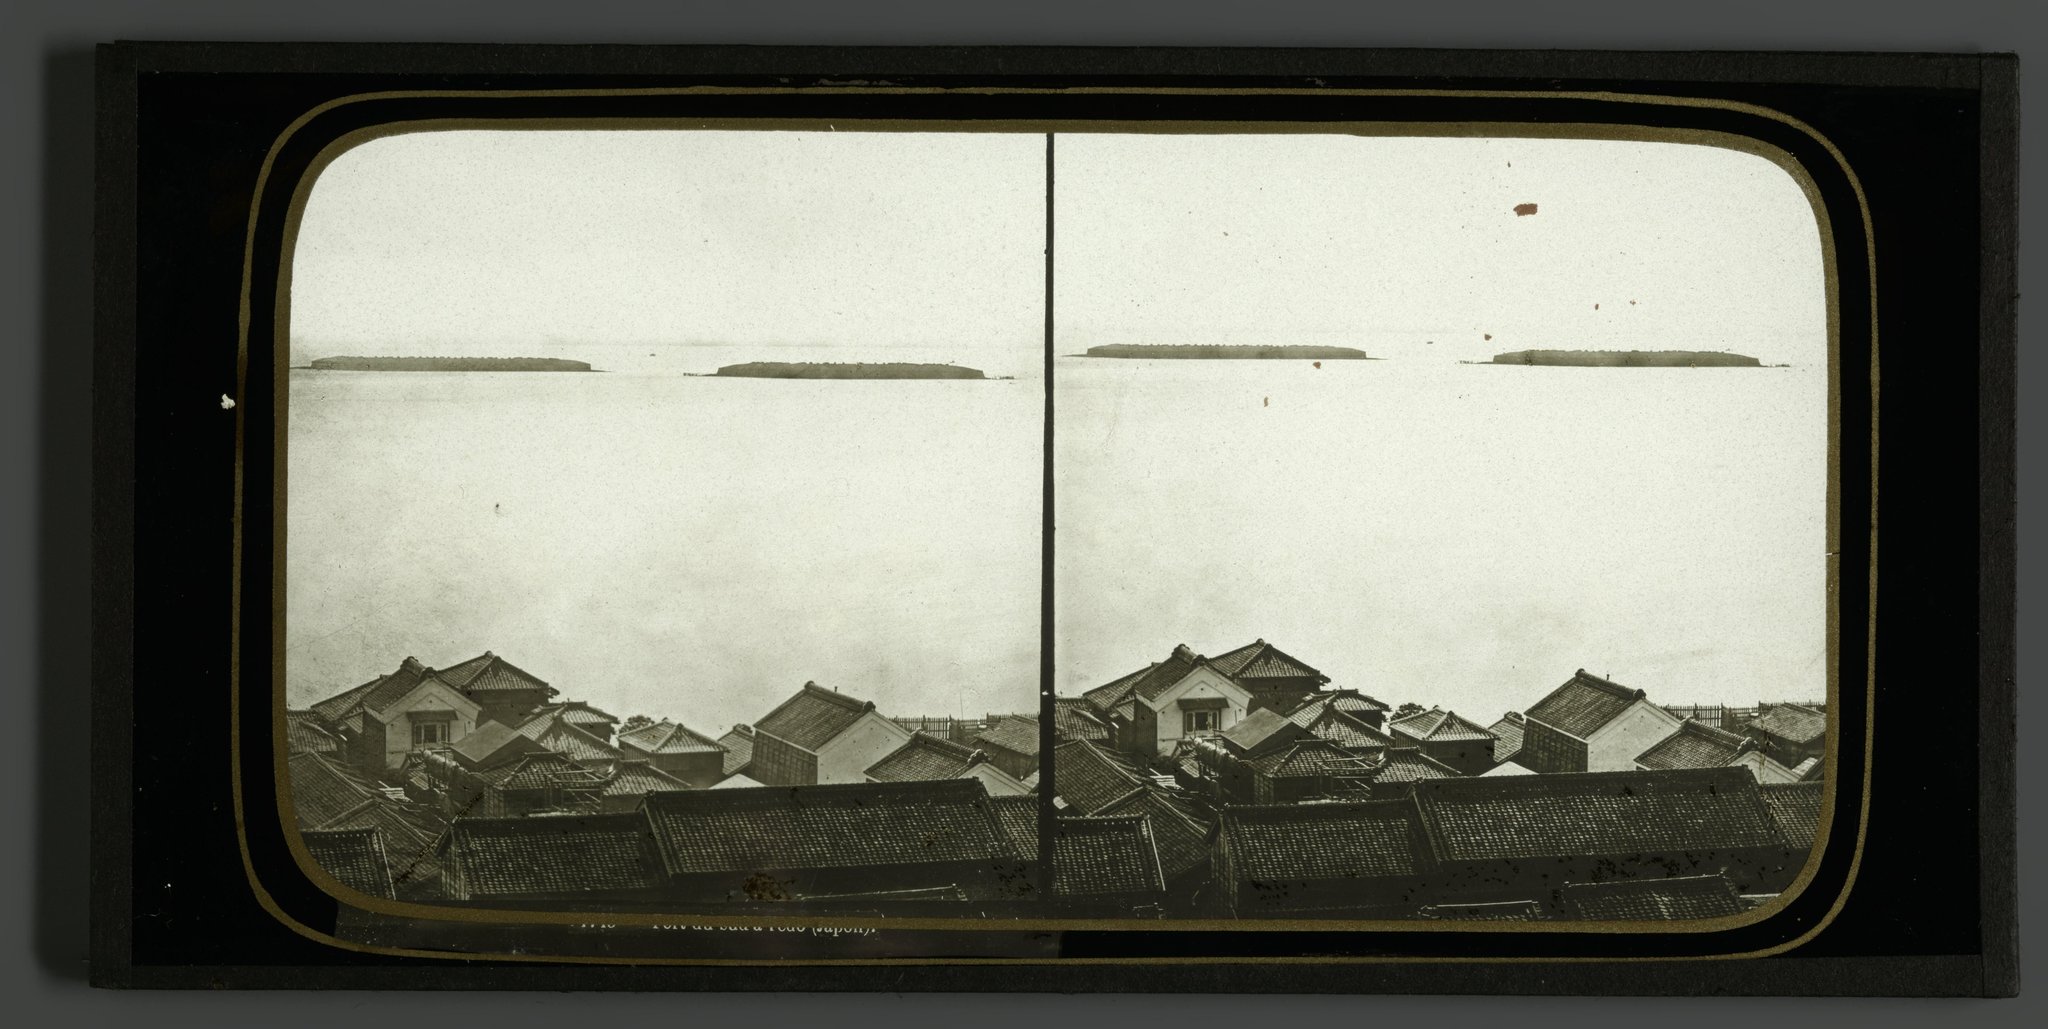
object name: photograph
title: Fort du Sud a Yedo (Japon)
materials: glass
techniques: slide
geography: tokyo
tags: ocean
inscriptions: number: ‘1740 [?]’